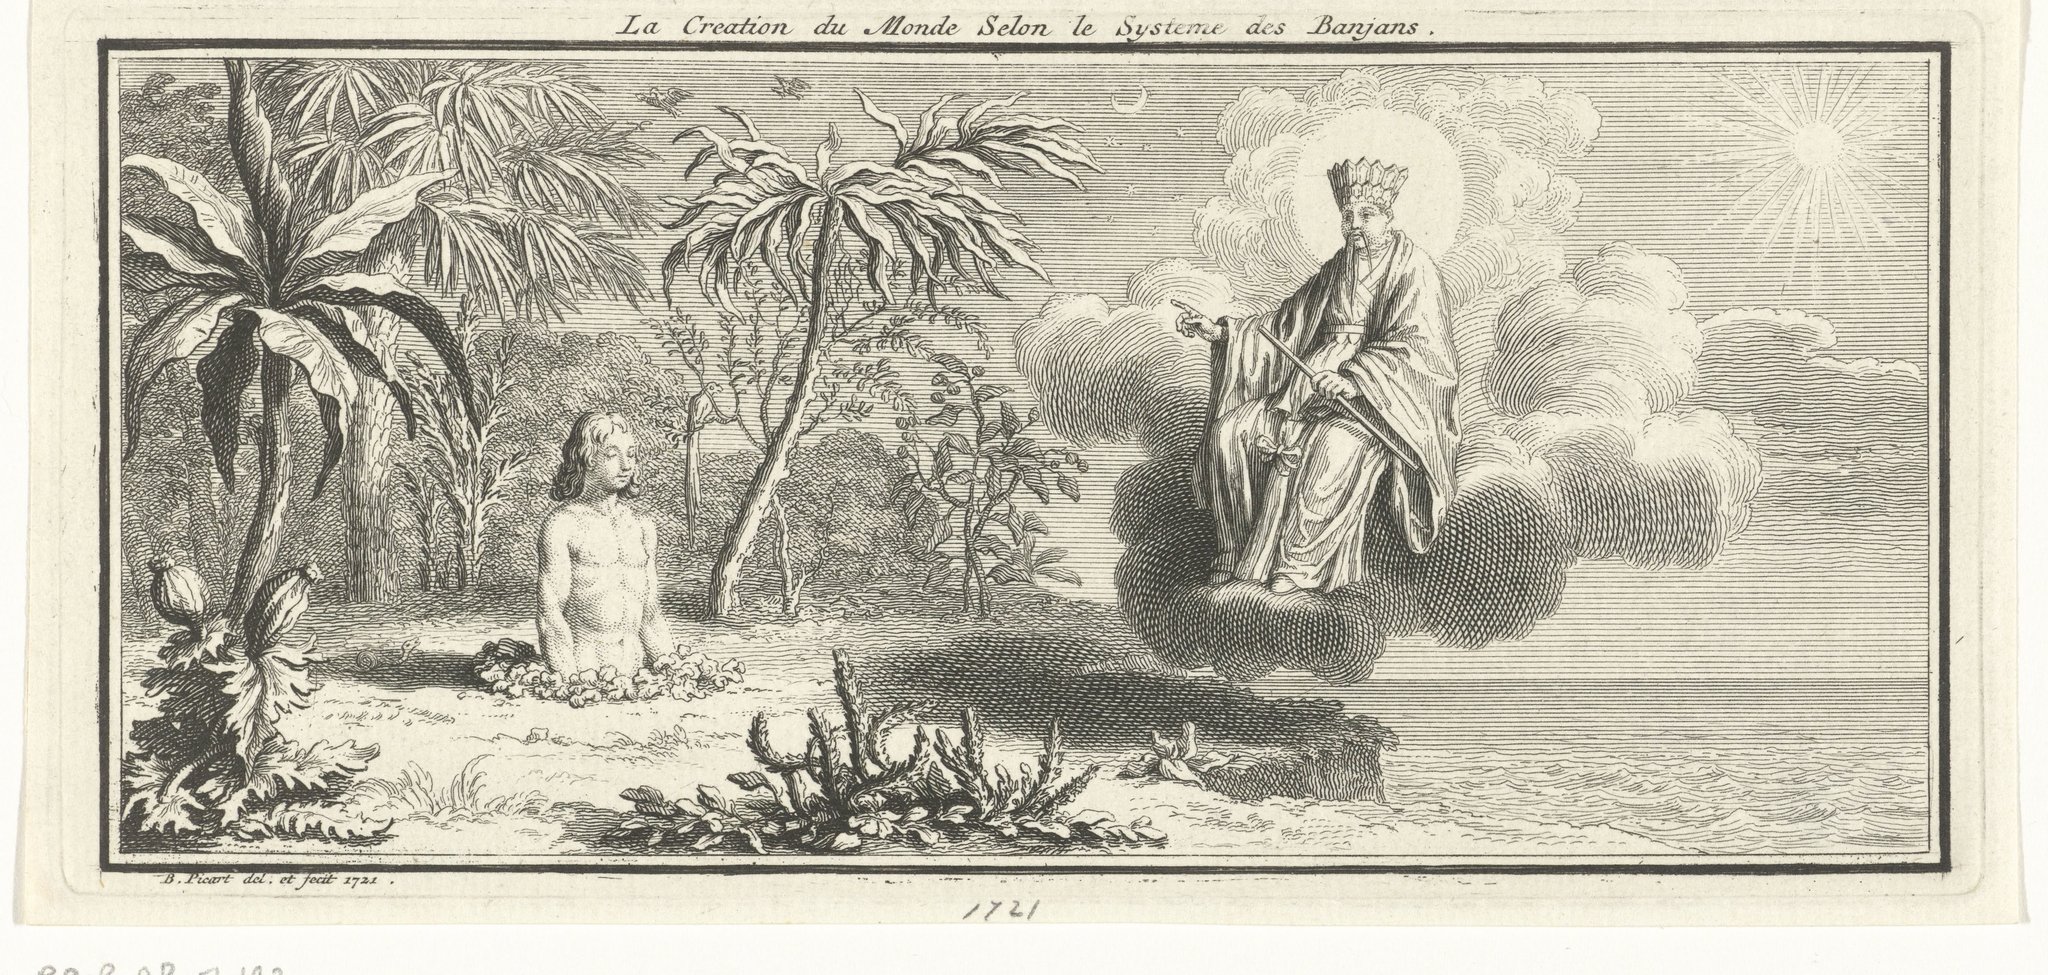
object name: print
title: De schepping volgens de Banjans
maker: bernard picart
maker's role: draughtsman, print maker, publisher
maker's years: 1673-1733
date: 1721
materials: paper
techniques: engraving, etching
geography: amsterdam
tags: tribal religions of south-east asia, creation of man by some creative force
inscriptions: collector's mark: Lugt 240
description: Prent ook gebruikt als illustratie in: Ceremonies et coutumes religieuses de tous les peuples du monde (...). Amsterdam: Jean Frederic Bernard, 1721.